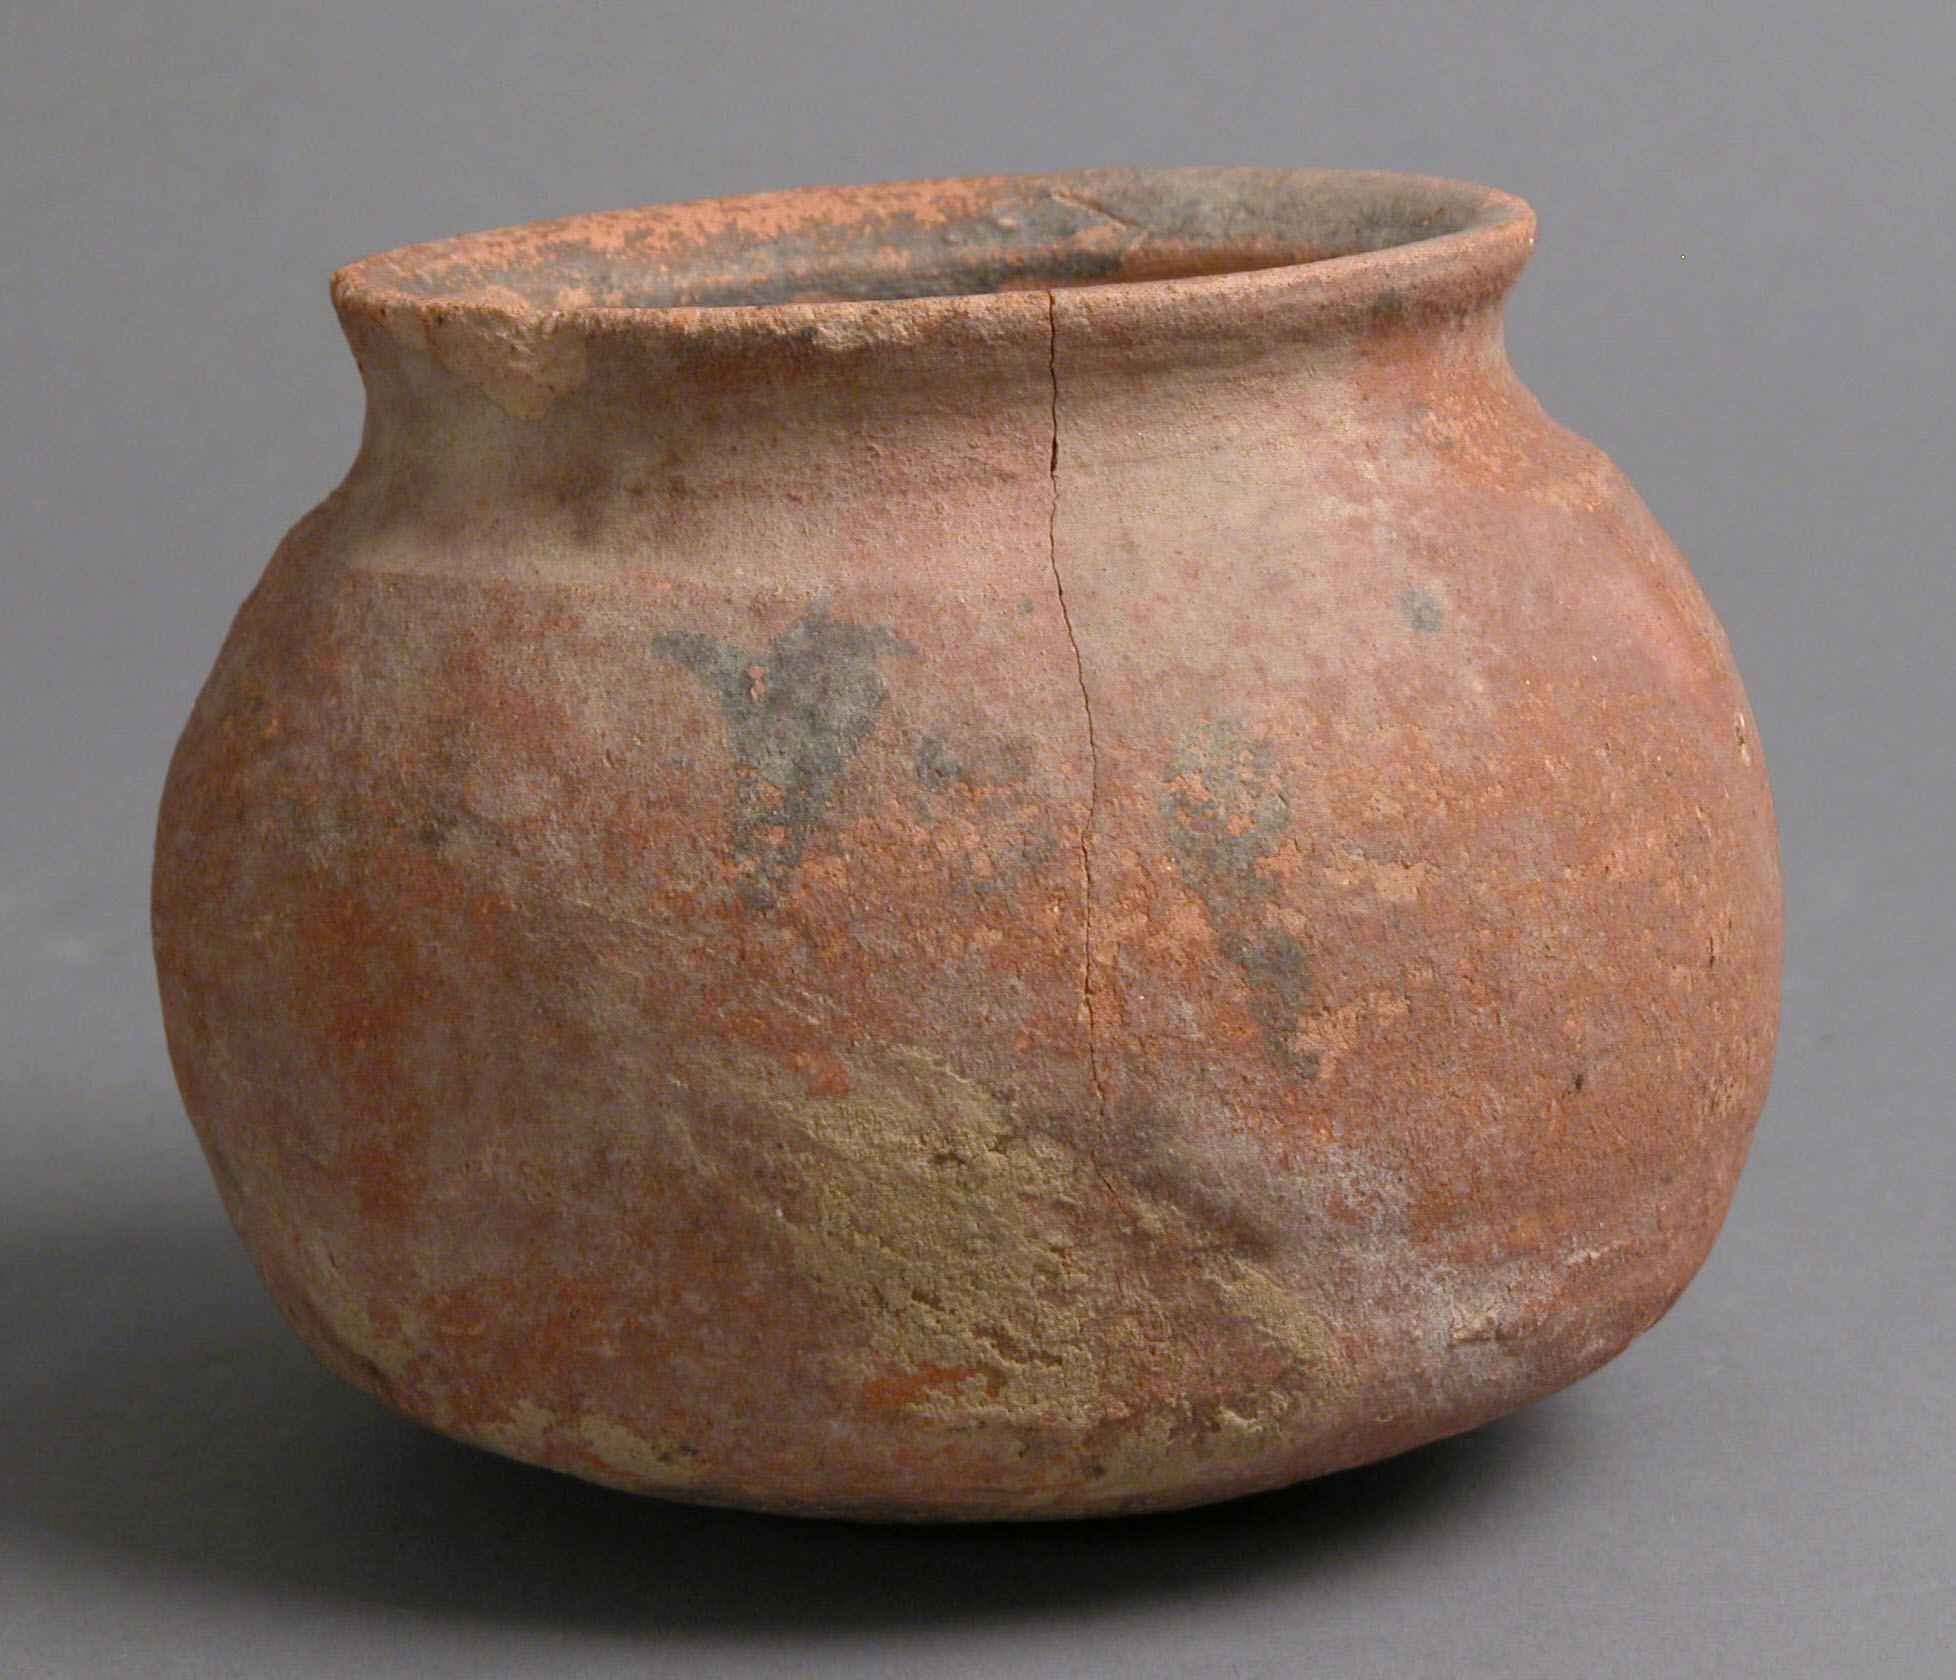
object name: pot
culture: coptic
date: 301-700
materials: earthenware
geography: egypt